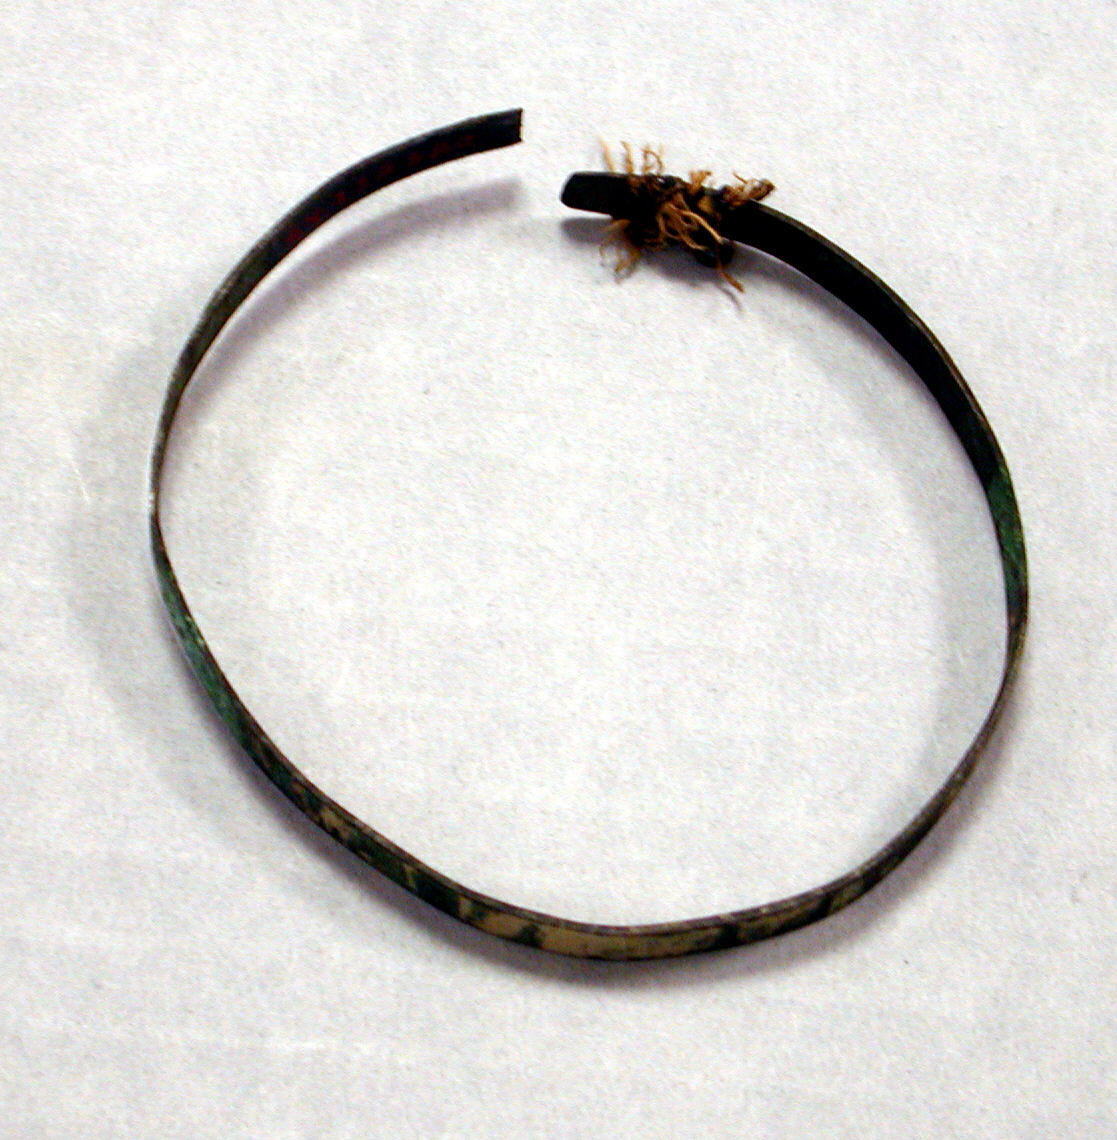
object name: ornament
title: Hammered Copper Band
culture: peruvian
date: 1450-1530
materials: copper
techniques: hammering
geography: peru